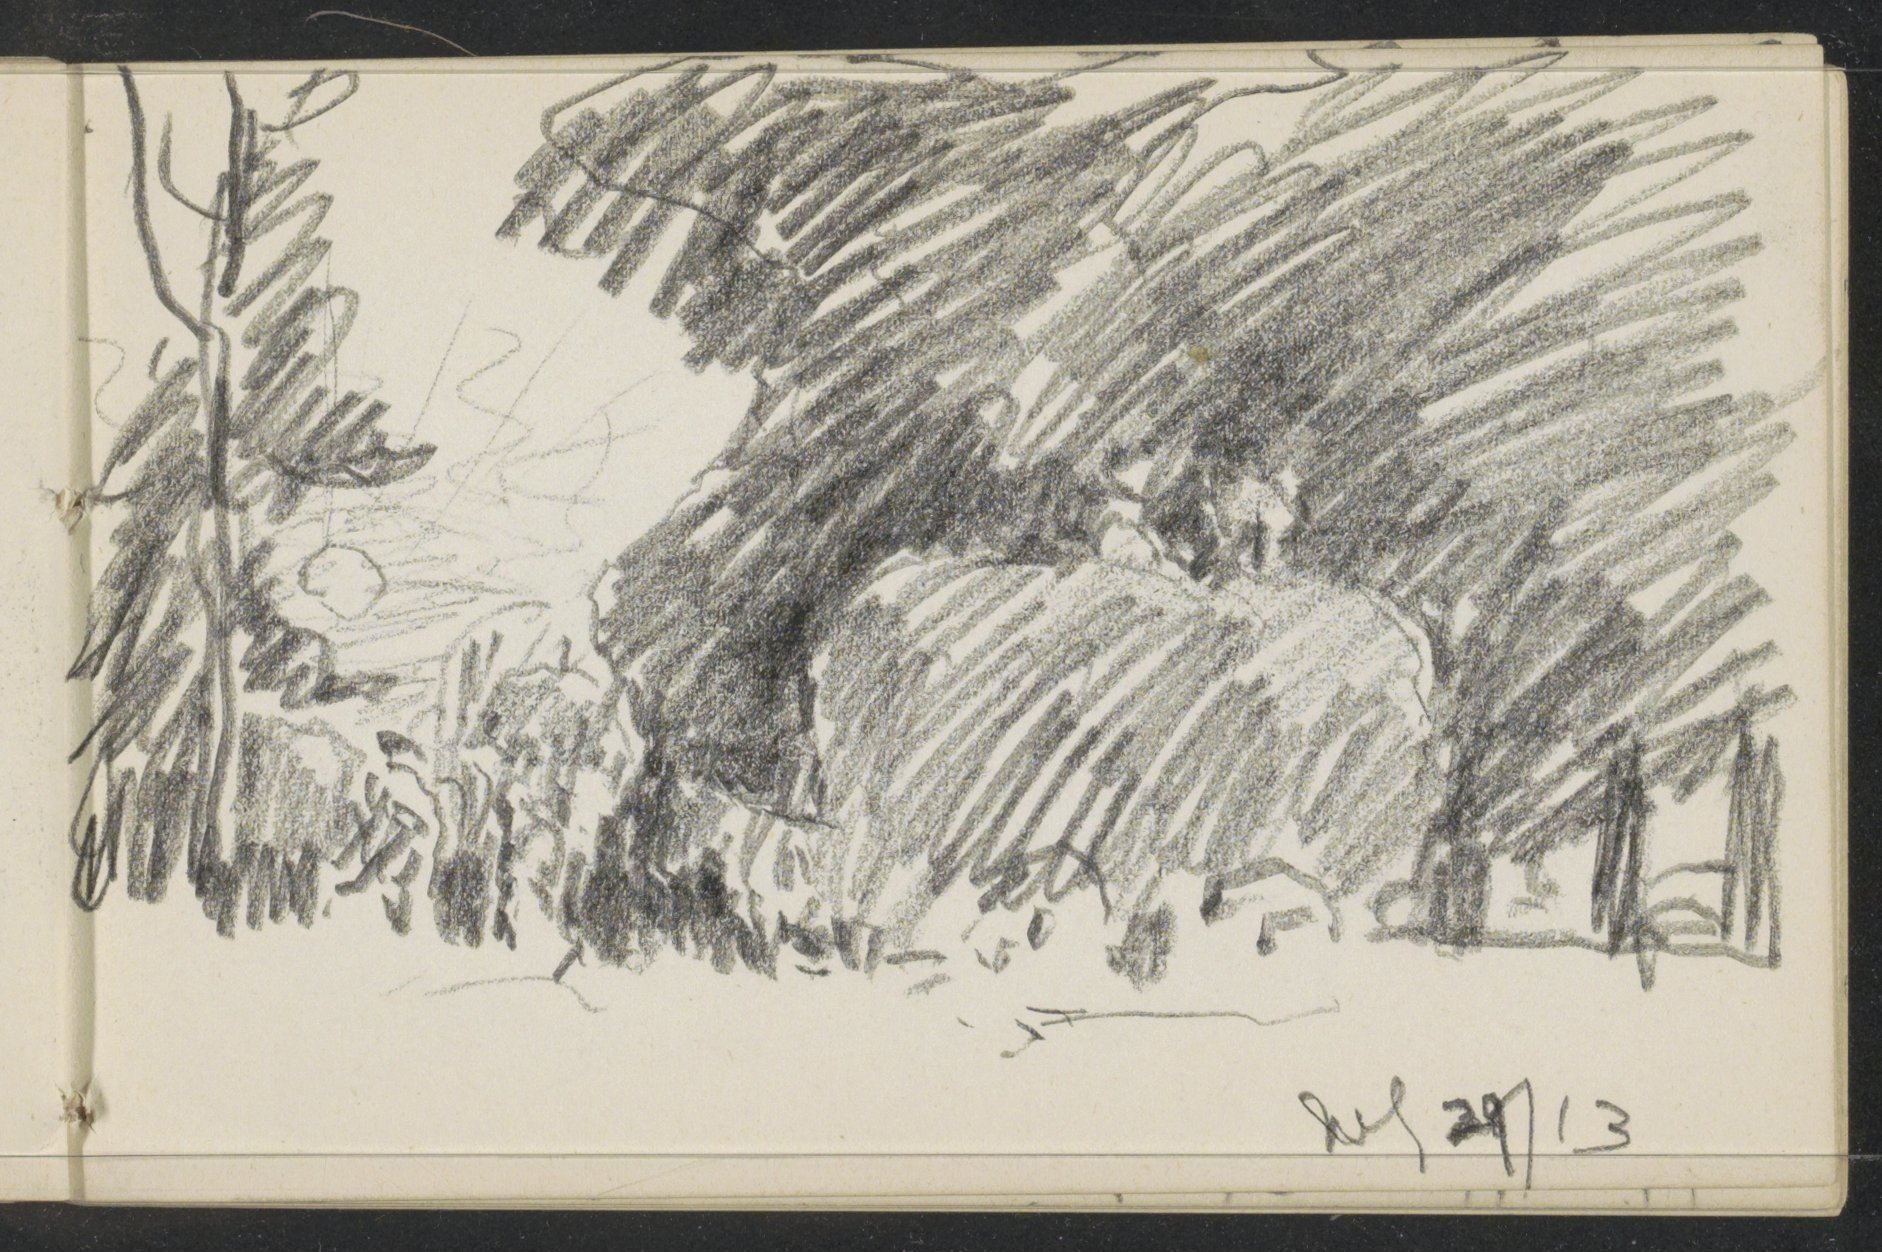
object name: sketchbook leaf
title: Landschap met figuren op een hooiwagen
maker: alexander shilling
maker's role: draughtsman, print maker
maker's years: 1859-1937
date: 1907-1913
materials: chalk, paper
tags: landscapes (+ landscape with figures, staffage)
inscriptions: date: ‘Jul 29/13’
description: Blad 14 recto uit een schetsboek met 30 bladen.